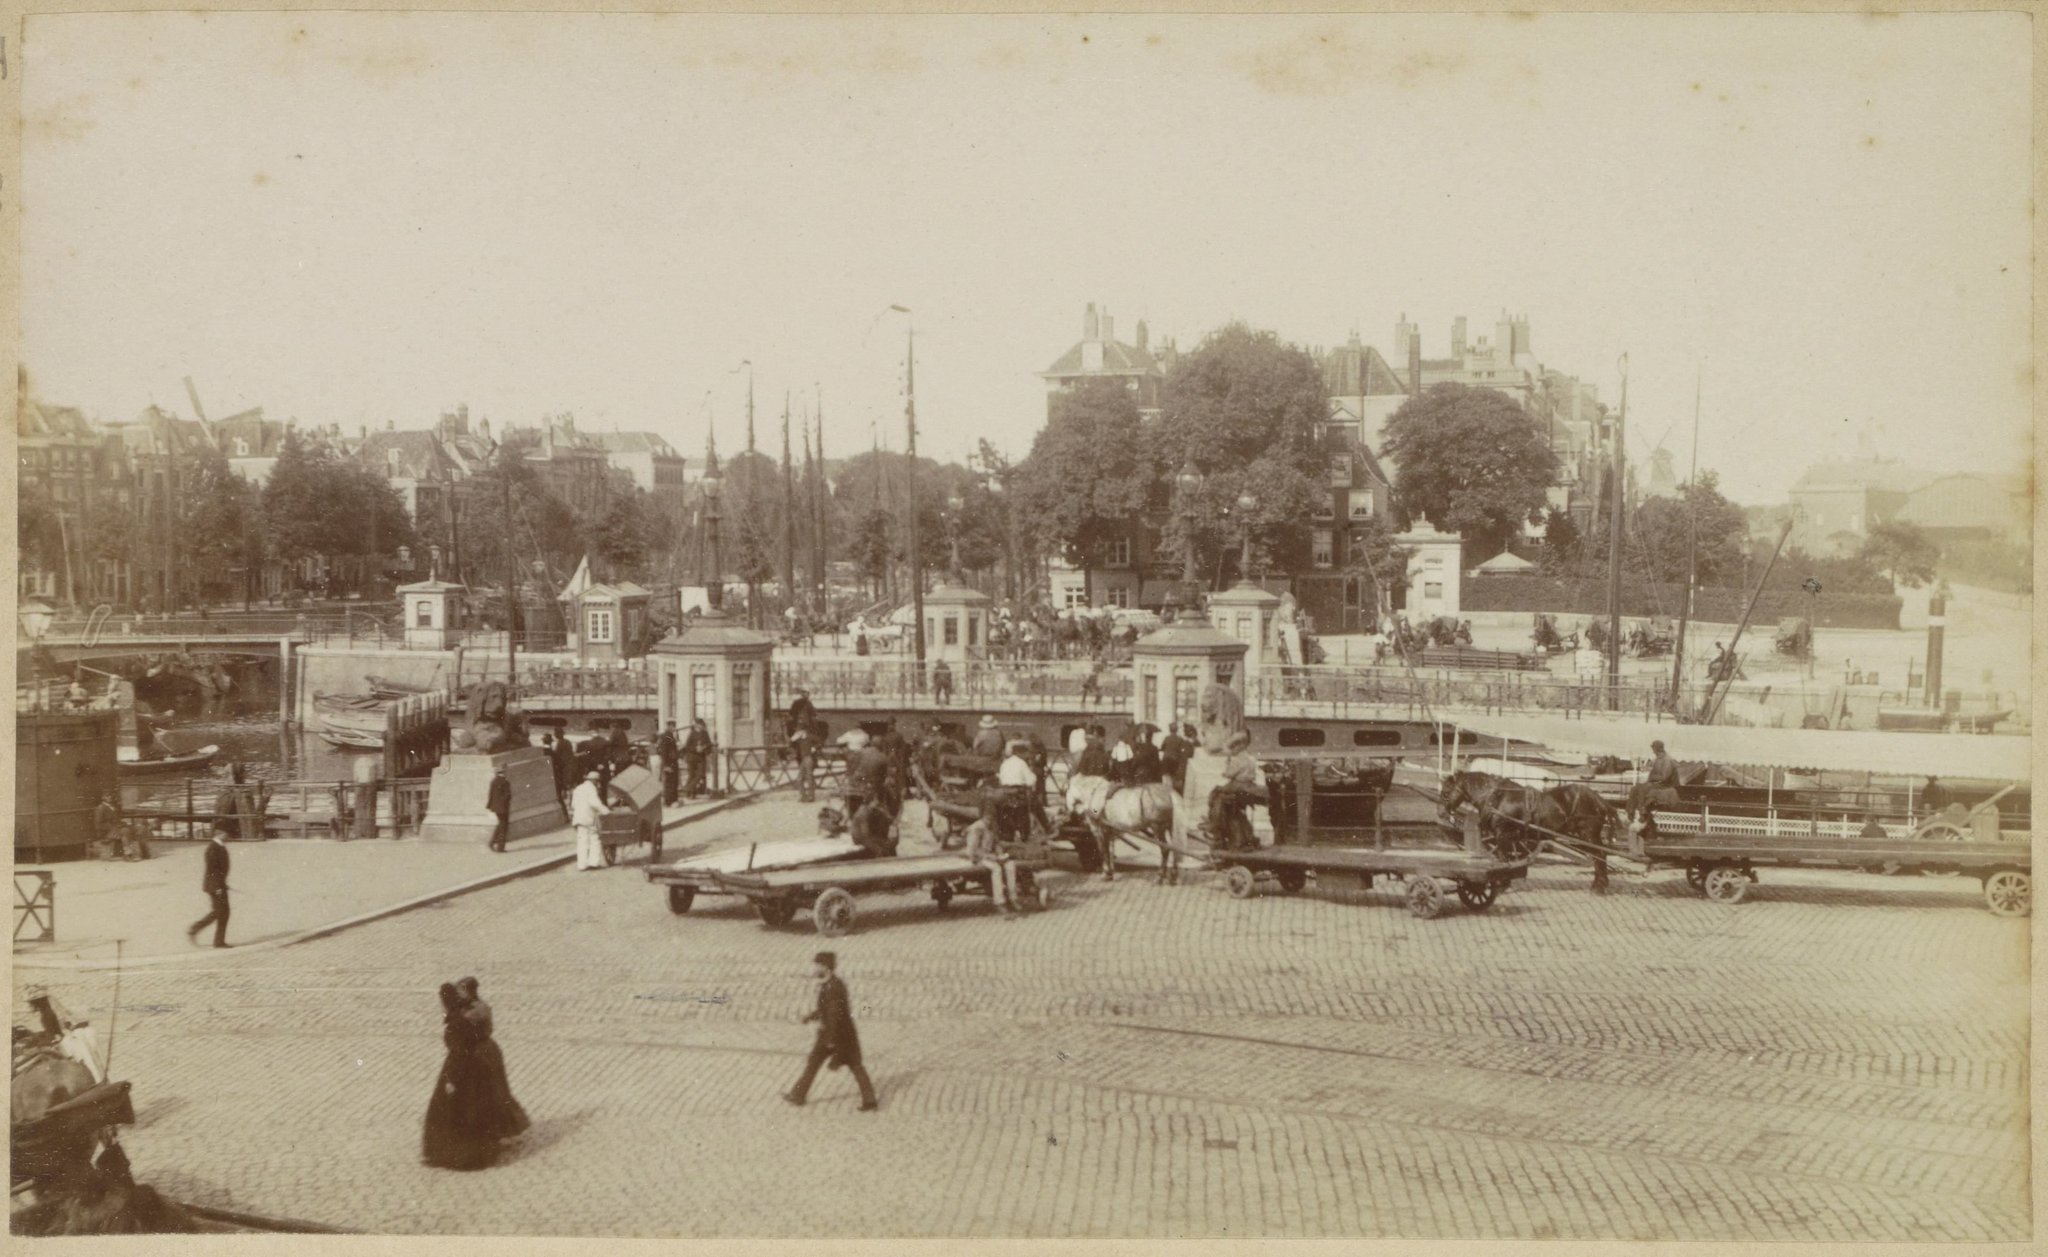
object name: photograph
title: Gezicht op de Koningsbrug over de Oude Haven in Rotterdam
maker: andries jager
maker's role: publisher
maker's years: 1825-1905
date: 1860-1900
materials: cardboard, photographic support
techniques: albumen print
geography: rotterdam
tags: bridge in city across river, canal, etc., rotterdam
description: Onderdeel van Leporelloalbum met foto's van Rotterdam.